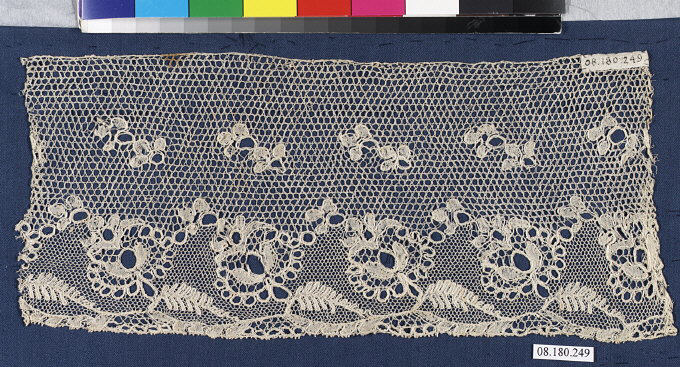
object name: piece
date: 1801-1900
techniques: lace